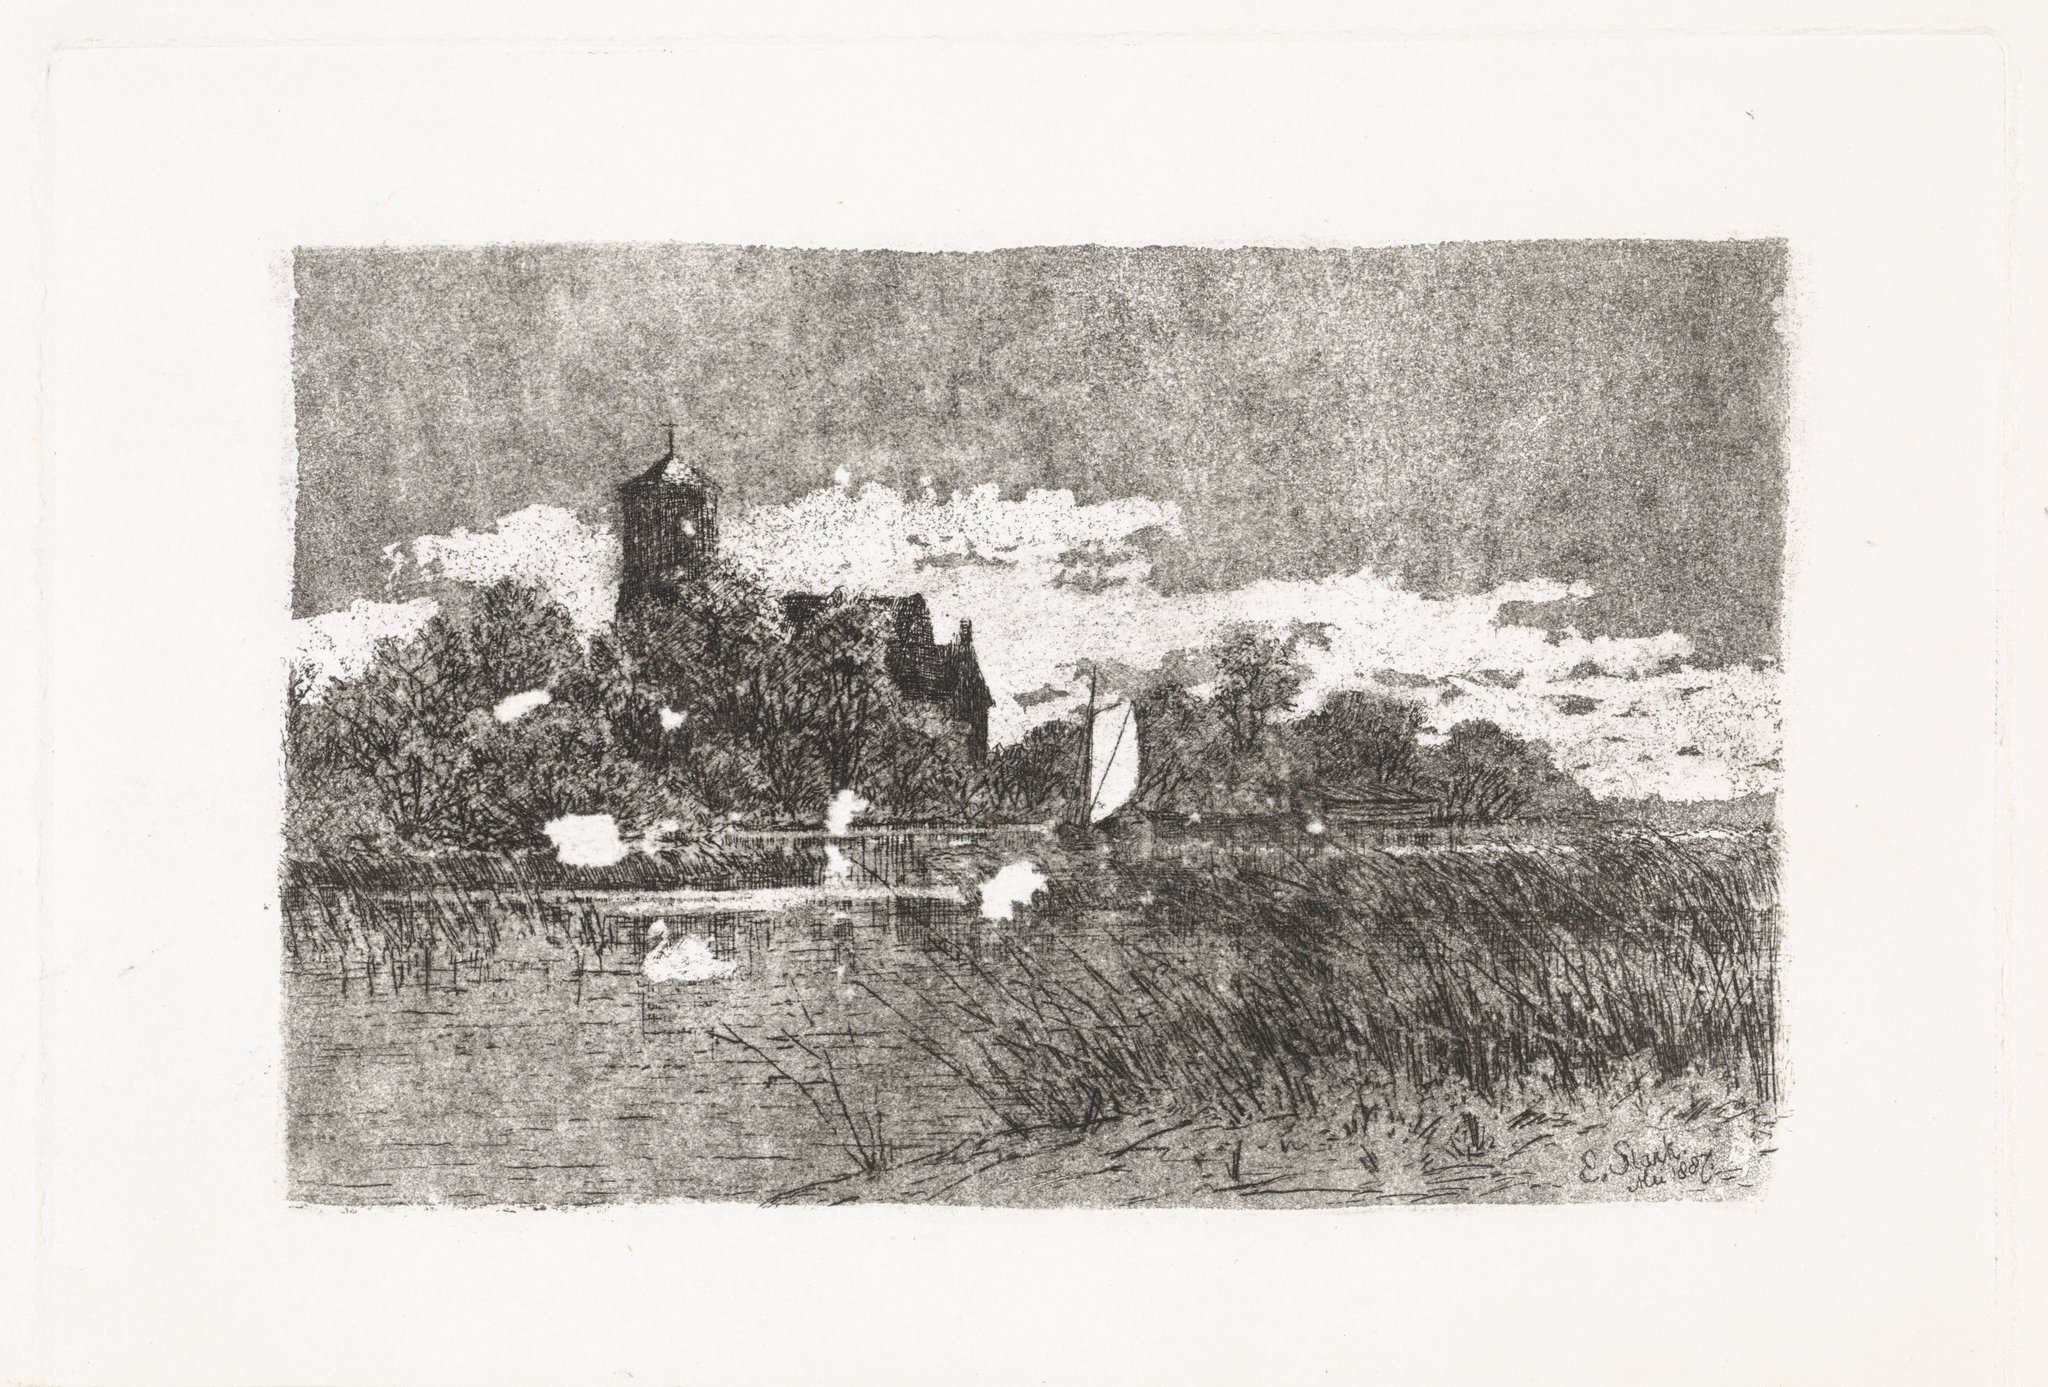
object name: print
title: Gezicht op de Sint Urbanuskerk te Bovenkerk met op het water een zeilscheepje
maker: elias stark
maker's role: draughtsman, print maker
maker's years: 1849-1933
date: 1805-1887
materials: paper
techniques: aquatint, etching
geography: nieuwer-amstel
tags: church (exterior)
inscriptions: collector's mark: Lugt 2228, inscription: ‘Bovenkerk bij pastoor Brouwers’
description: Gezicht op de St. Urbanuskerk te Bovenkerk met op de voorgrond op het water een zeilscheepje en zwanen.